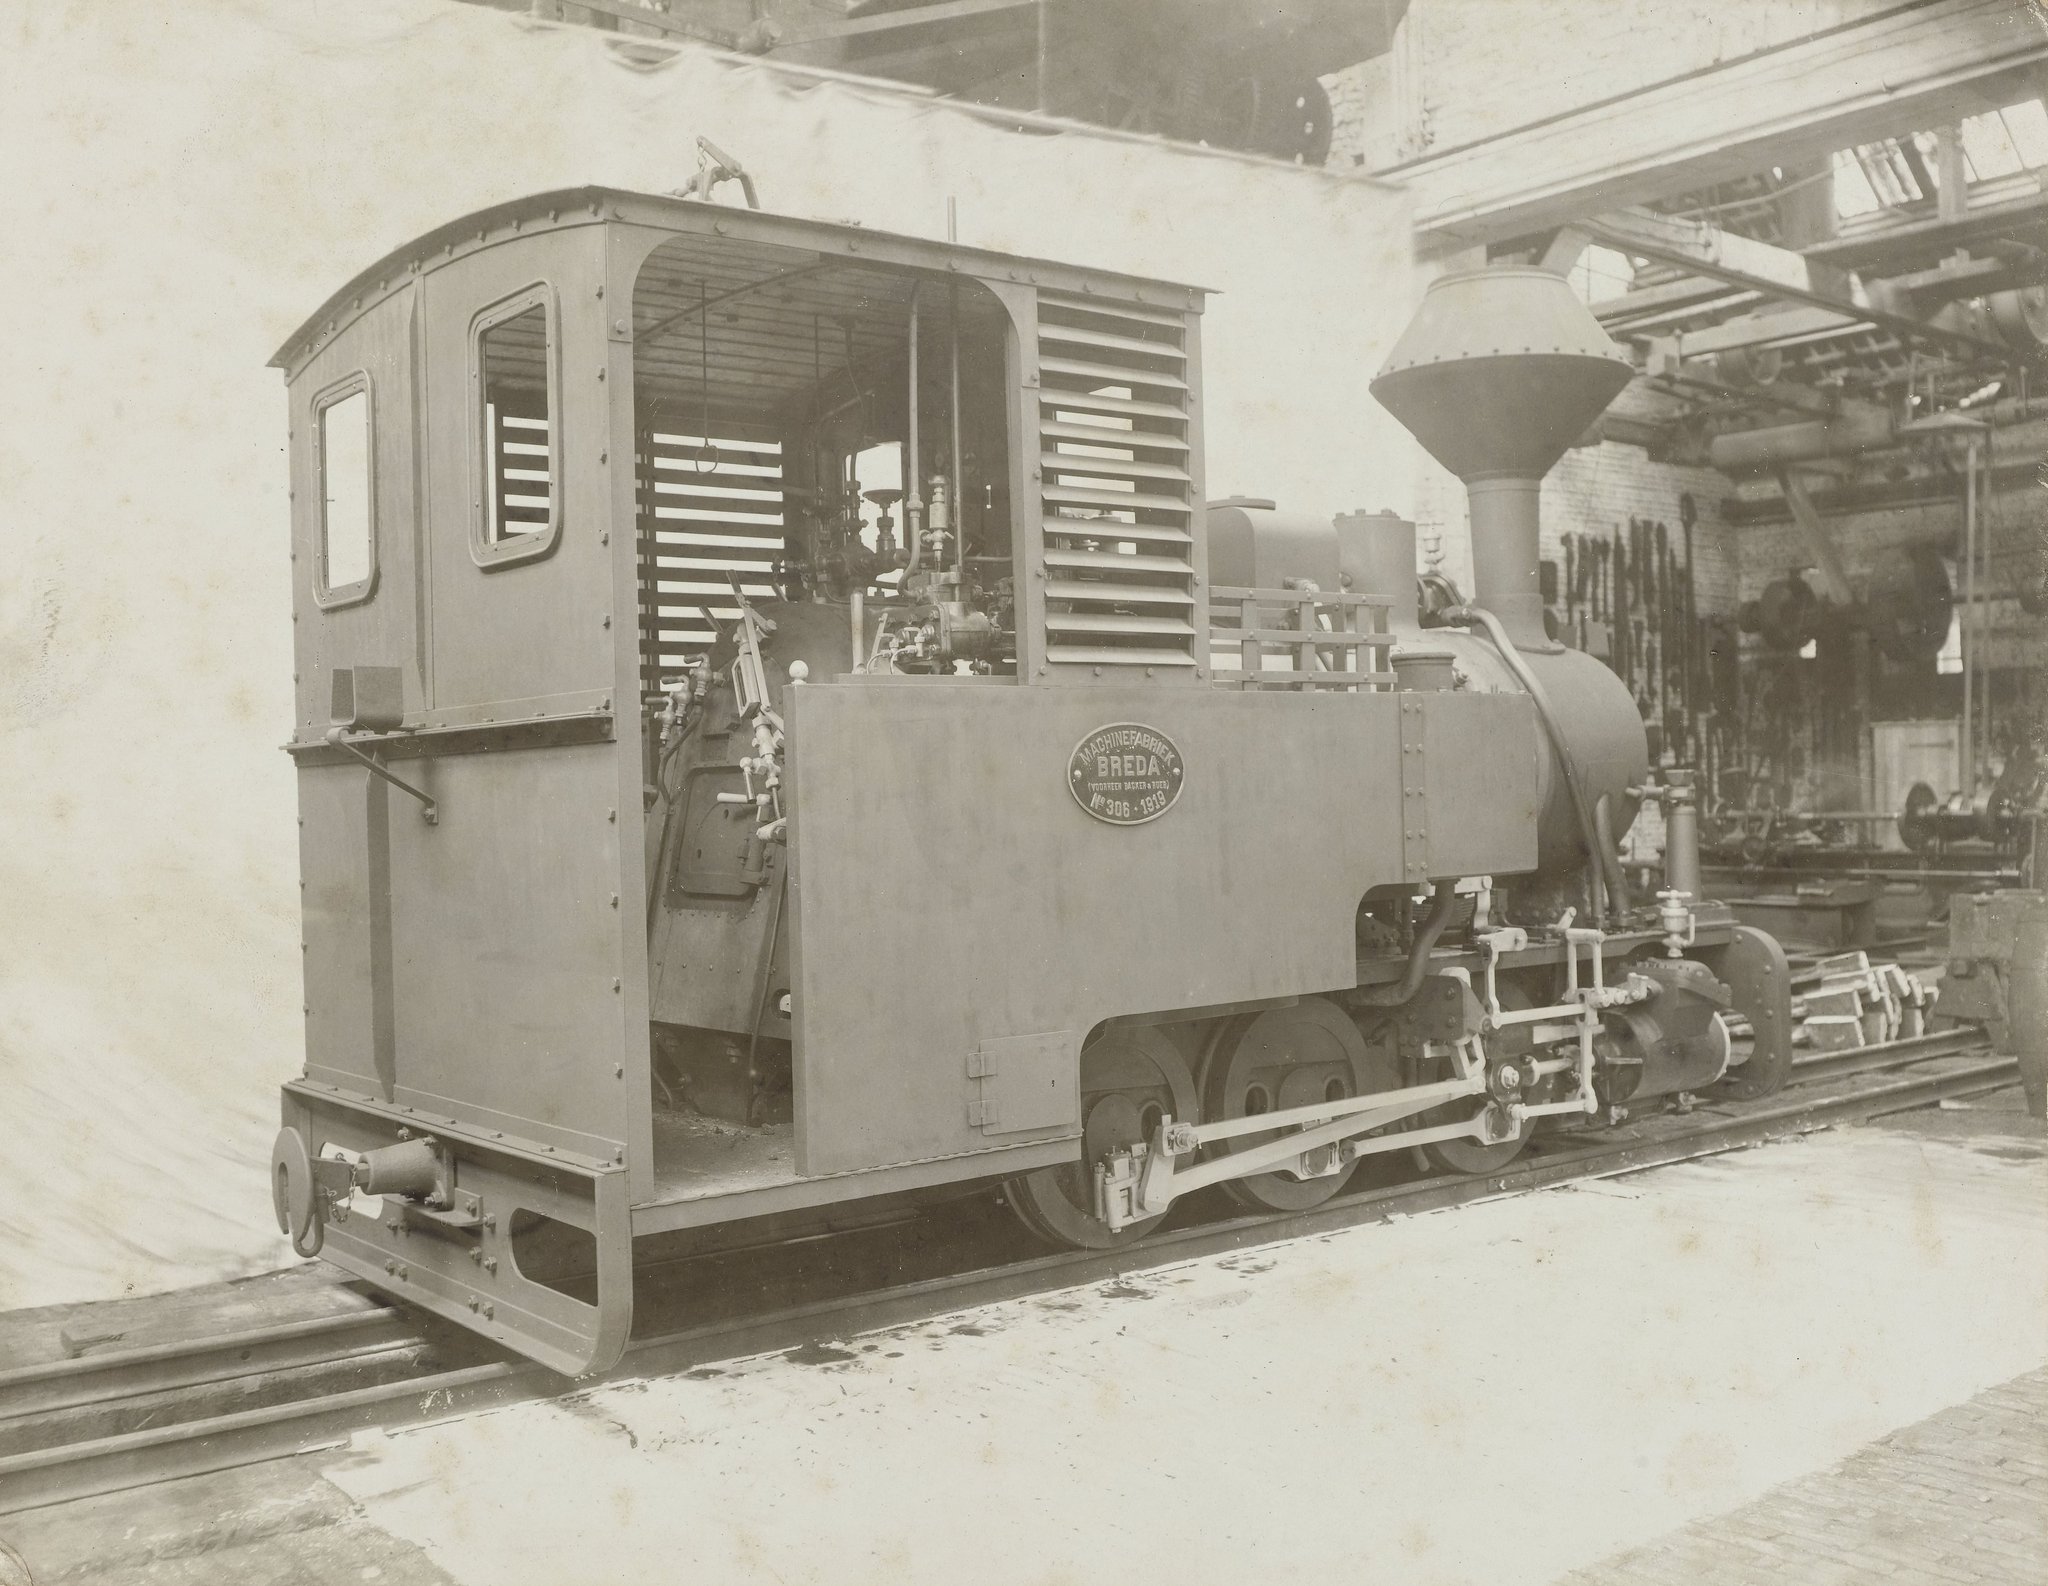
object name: photograph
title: Een suikerlocomotief van de Nederlandsch-Indische Spoorwegen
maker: Anonymous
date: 1900-1919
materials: paper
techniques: photography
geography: breda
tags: dutch east indies, the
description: Een stoomlocomotief in de fabriek. Door de deur is de kolenmachine te zien. De laatste stoomlocomotief die door machinefabriek Breda is gebouwd, in 1916 verscheept naar de voormalige kolonie Nederlands-Indië. Gebruikt door de Banka en Biliton Mij. Gemaakt door de Machinefabriek Breda, nr. 306 - 1919.